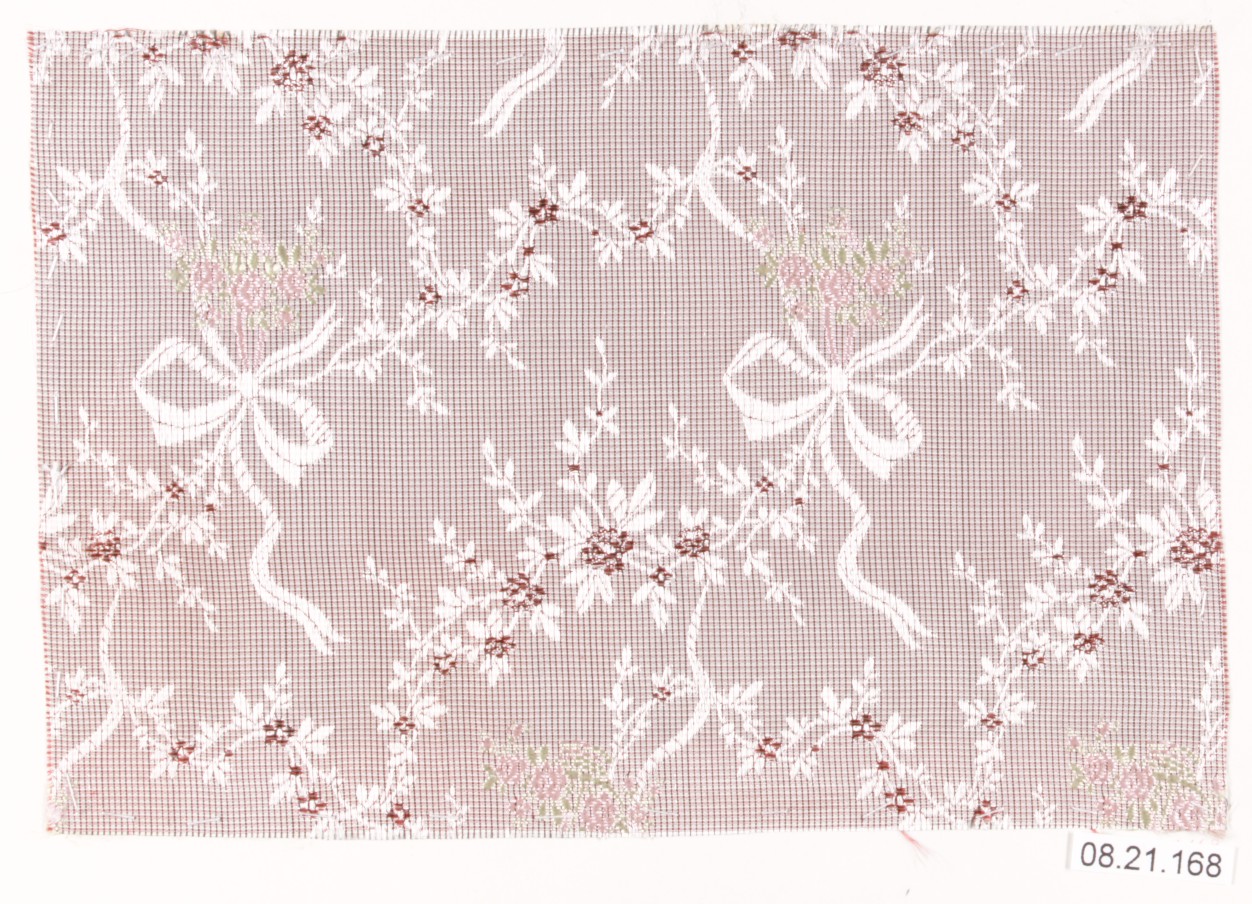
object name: textile sample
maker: Anonymous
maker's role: designer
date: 1900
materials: silk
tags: flowers